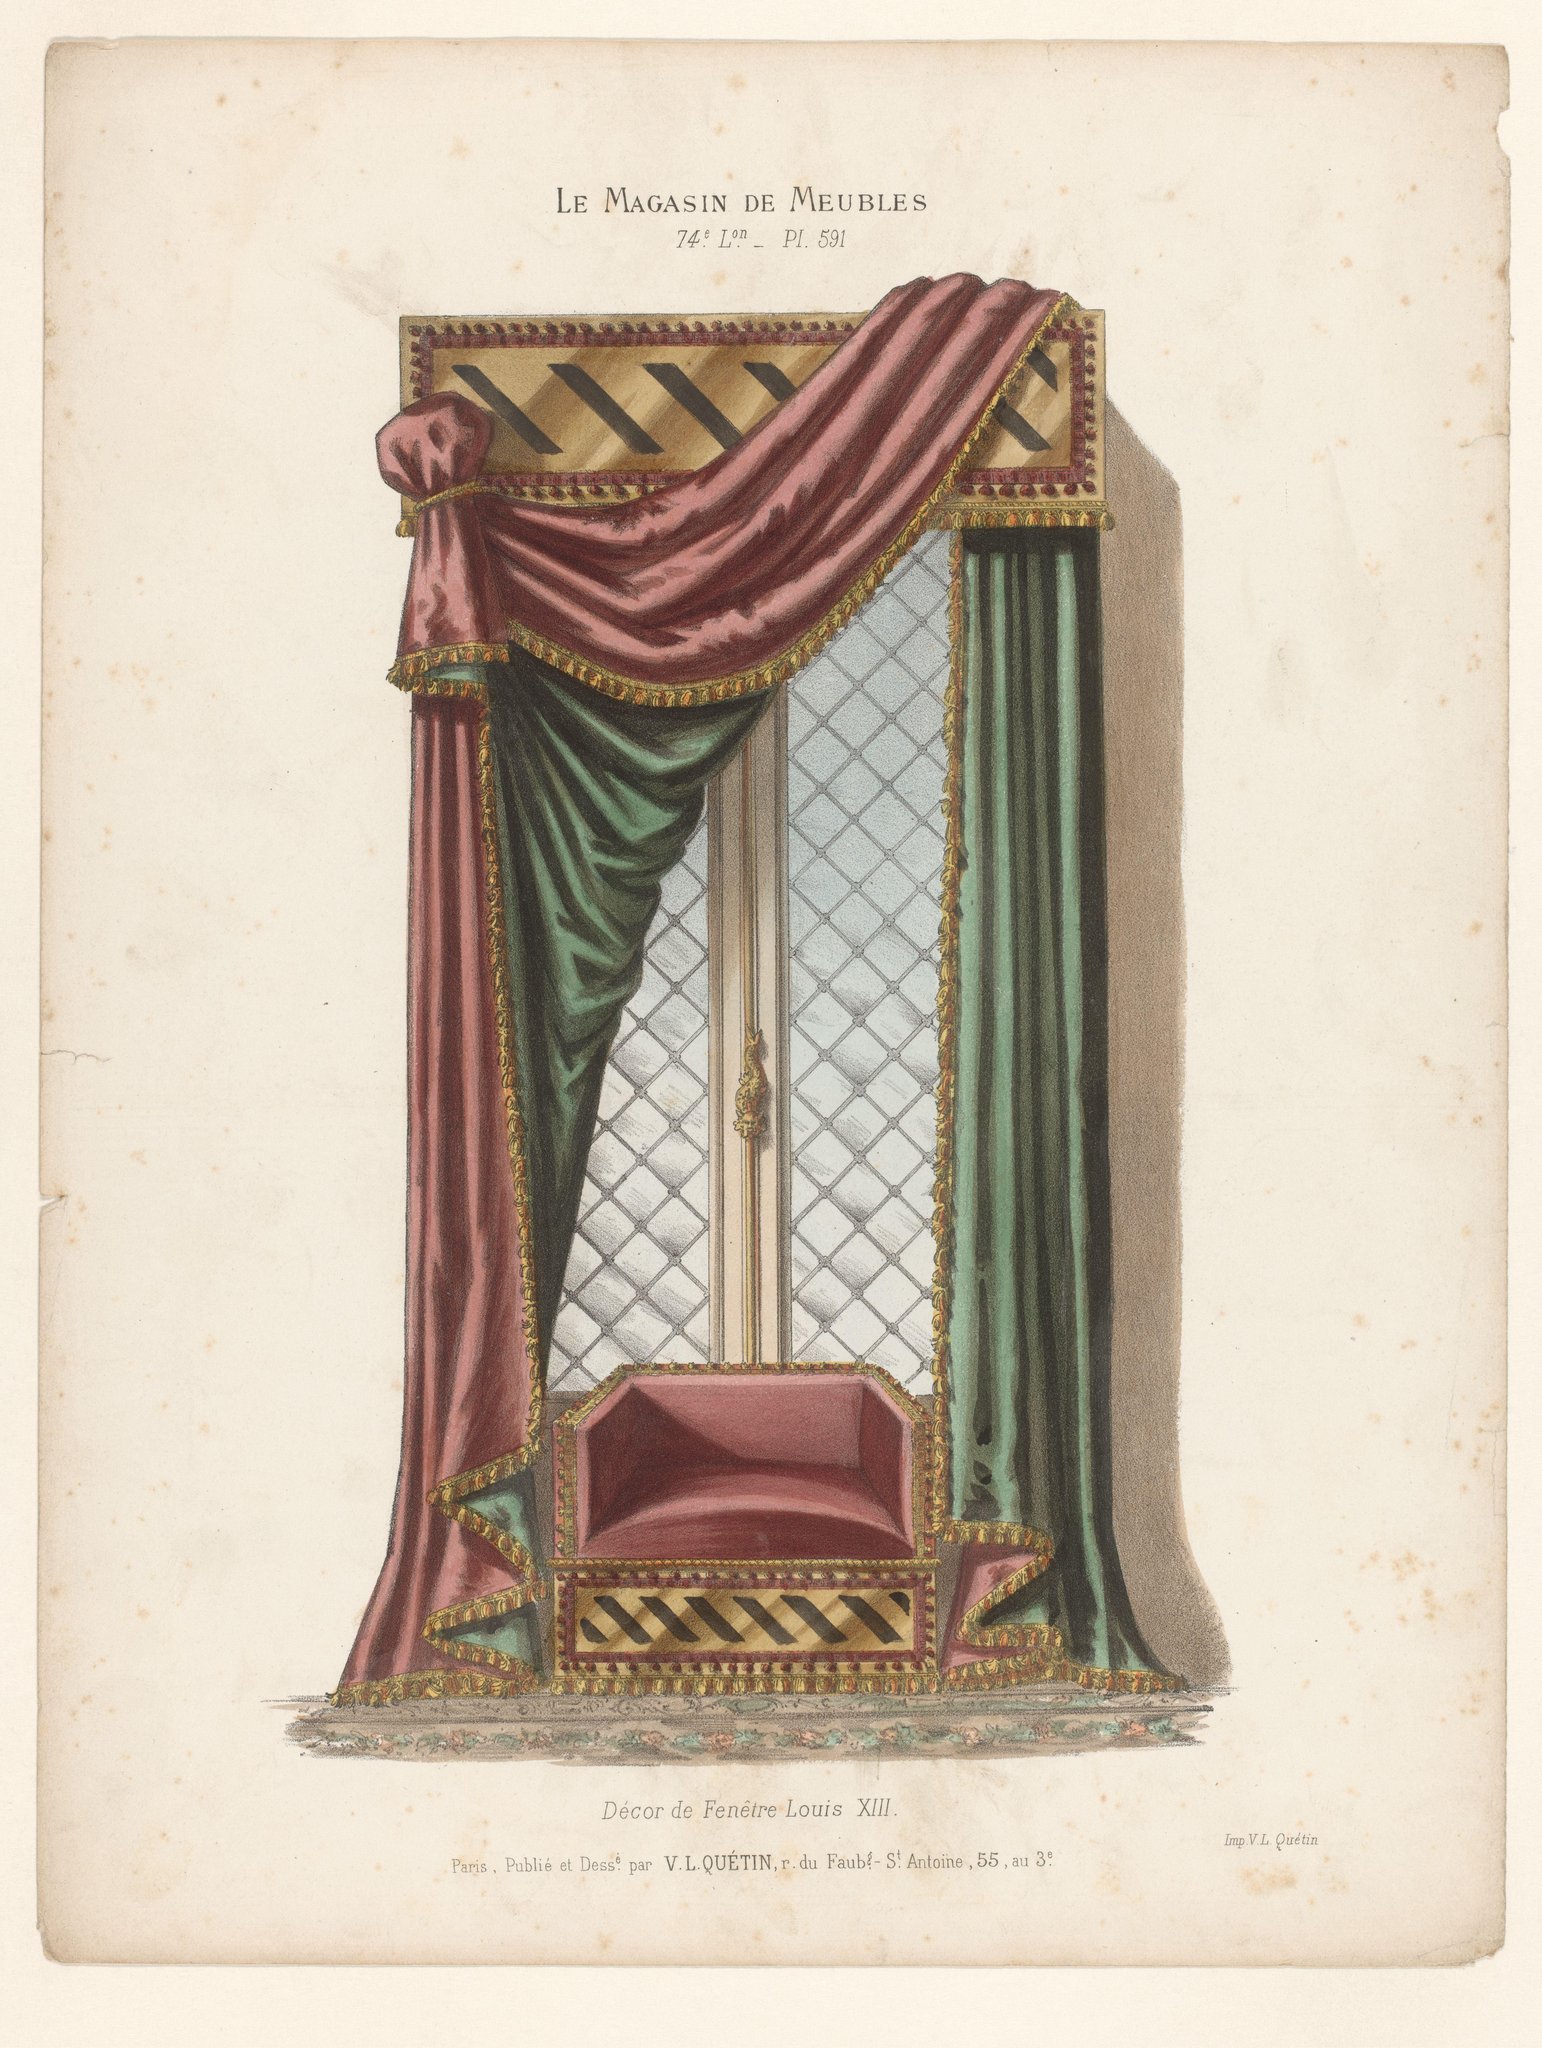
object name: print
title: Le Magasin de Meubles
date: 1878-1904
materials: paper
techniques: hand coloring, lithograph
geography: paris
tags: window, hangings and drapery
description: Een venster met gedrapeerde gordijnen in de Lodewijk XIII-stijl. Voor het venster staat een fauteuil. Prent uit 74e Livraison.